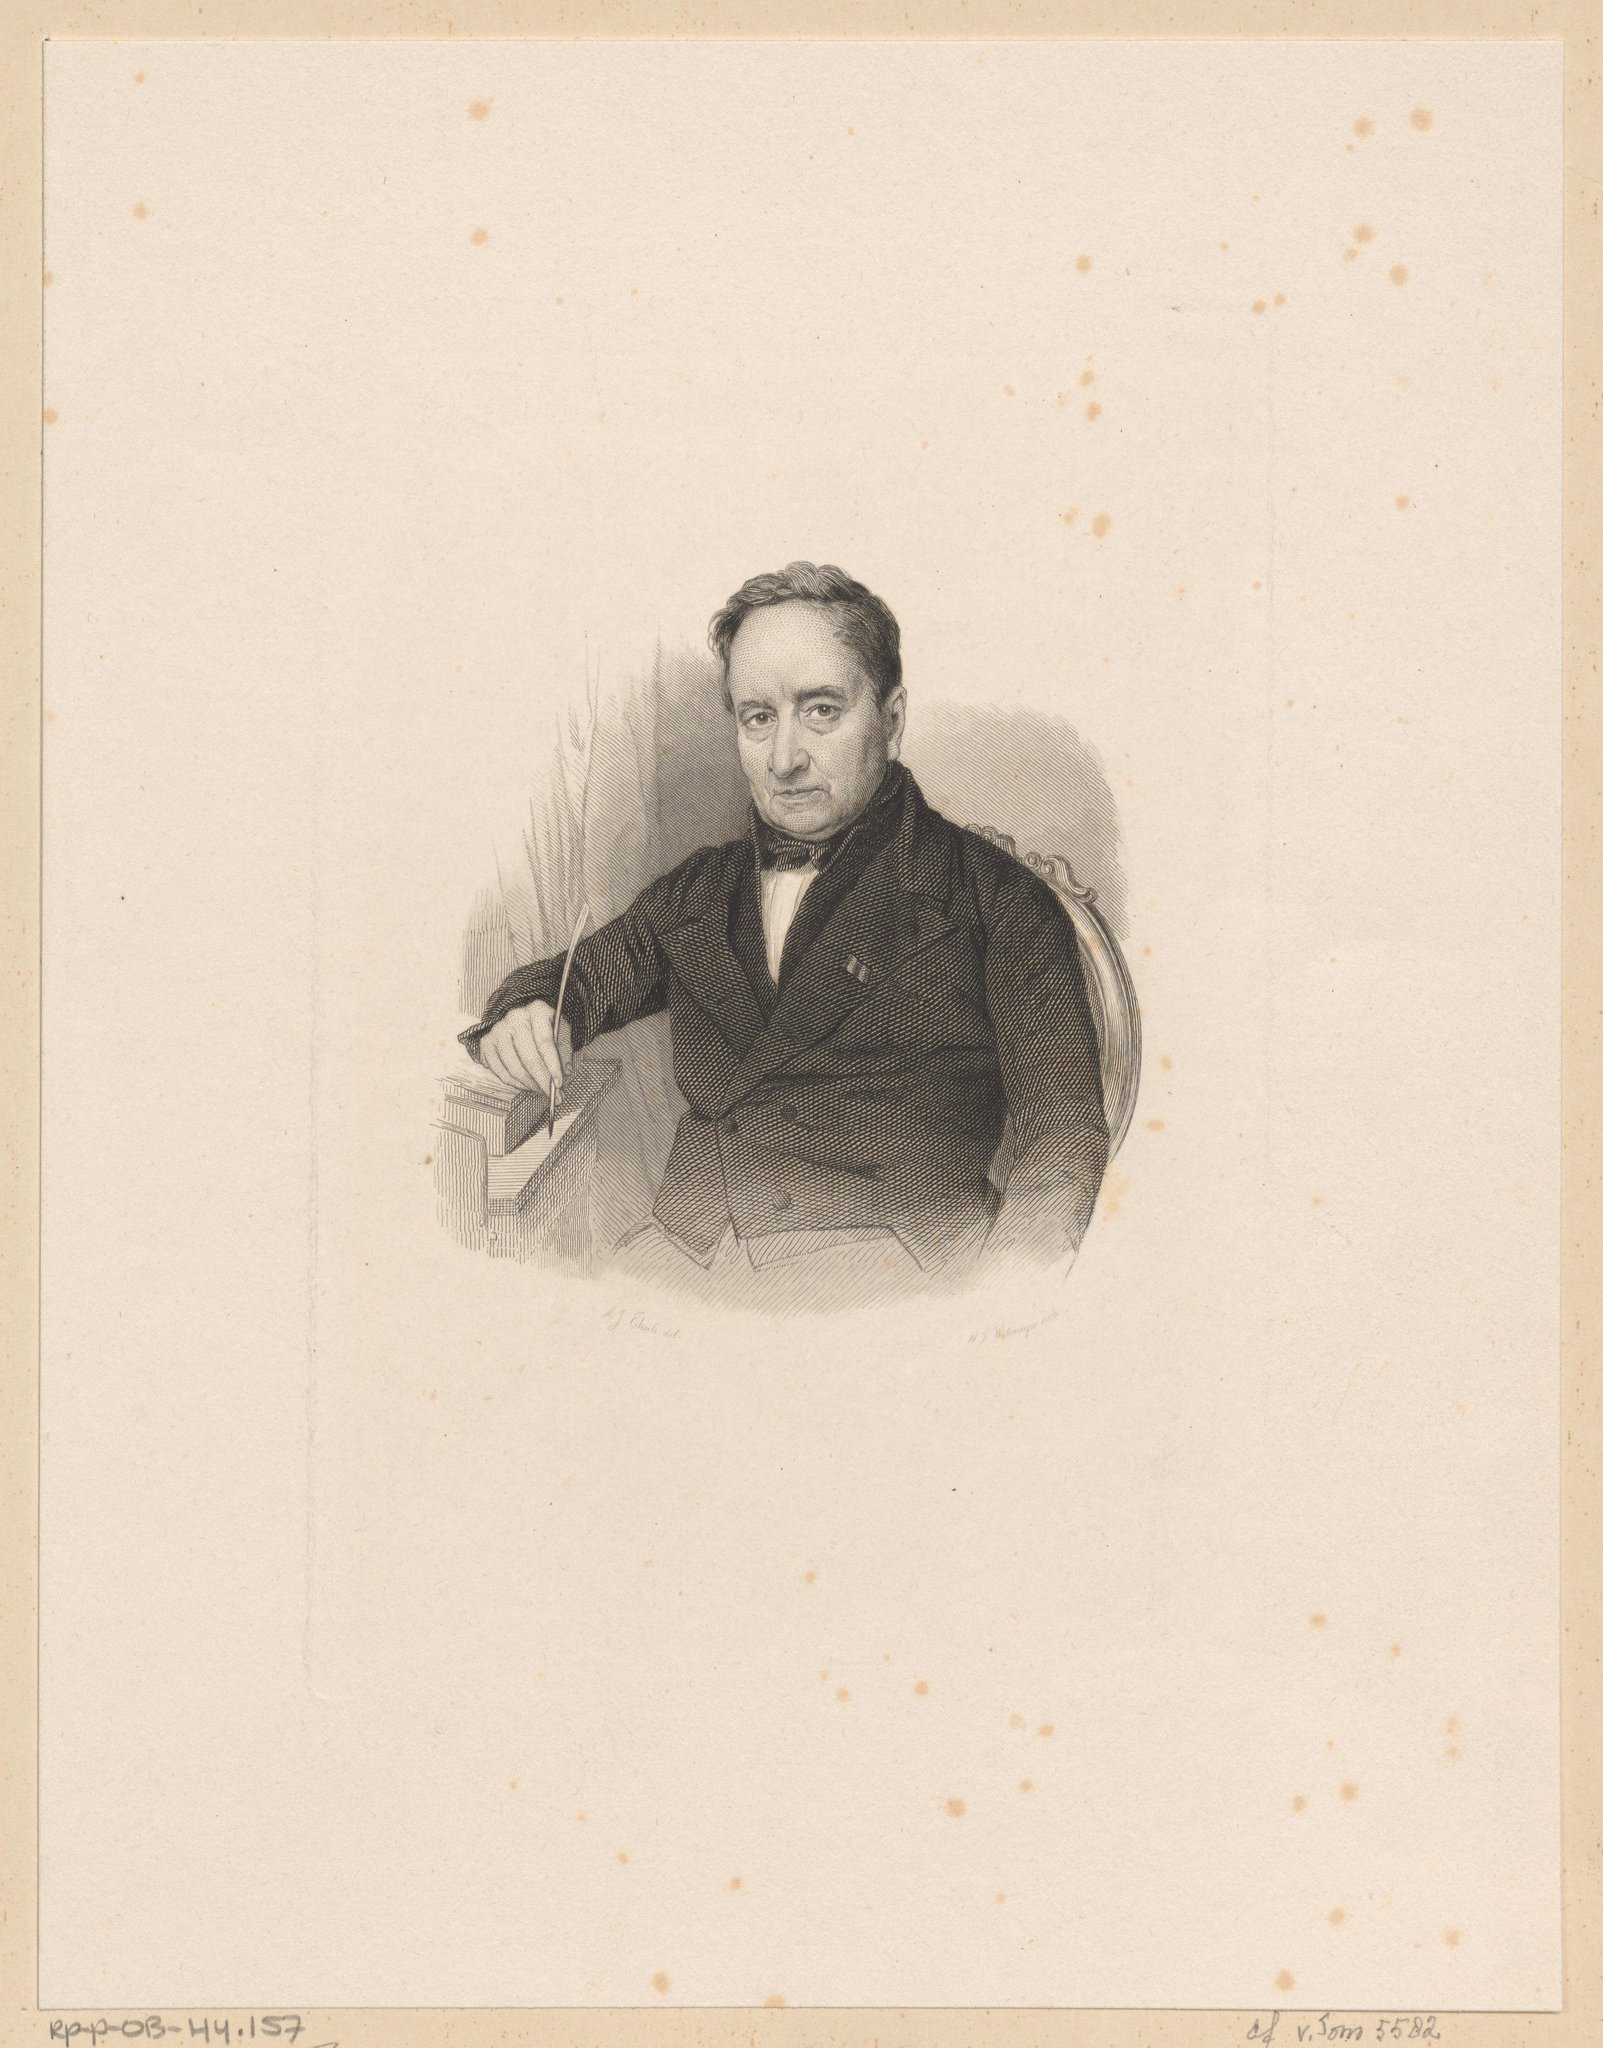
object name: print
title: Portret van Hendrik Tollens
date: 1834-1854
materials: paper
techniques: engraving, etching, roulette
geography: netherlands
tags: rotterdam, hendrik tollens, historical persons, portrait of a writer, chair